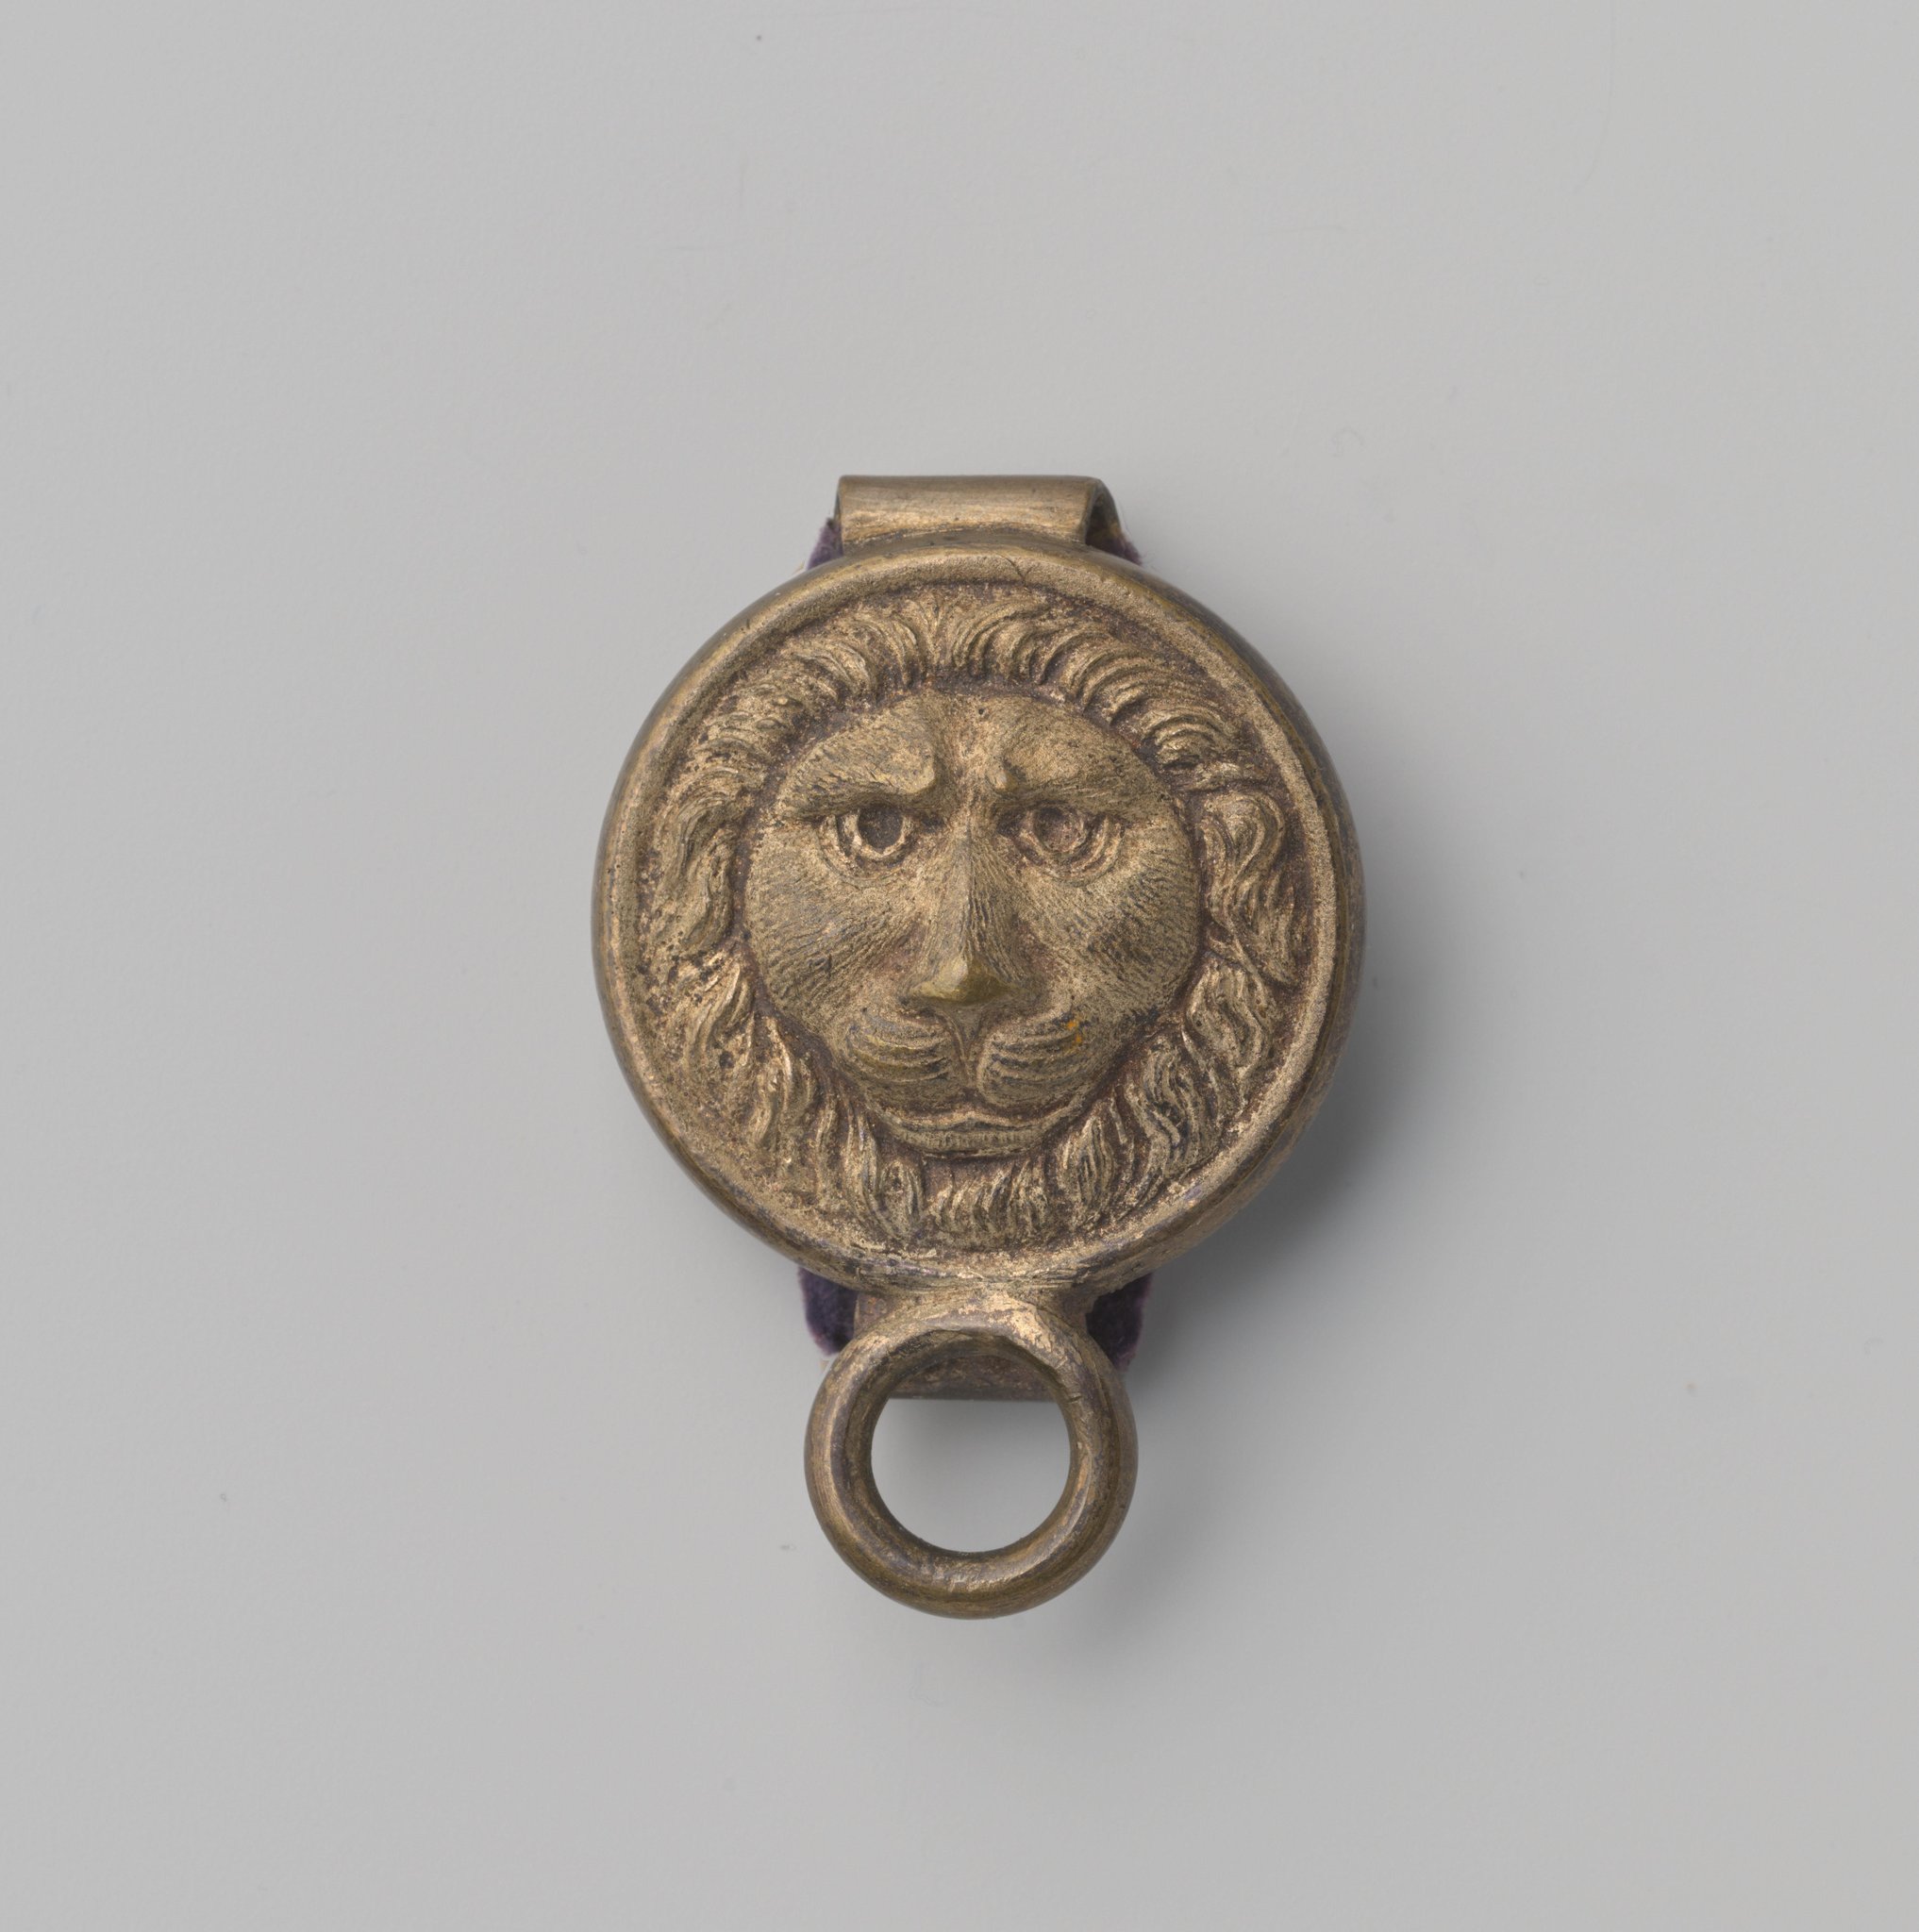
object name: buckle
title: Ronde gesp in de vorm van een leeuwenkop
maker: Anonymous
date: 1900-1925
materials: metal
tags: eugen wachenheimer, else wachenheimer-moos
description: Dit object is onderdeel van de nalatenschap van Isabel Elon-Wachenheimer (1928-2010). Tot haar overlijden behoorde het samen met de andere objecten uit de nalatenschap tot haar privédomein van Isabel Wachenheimer. In die particuliere context zijn deze objecten tezamen en individueel aandenkens - aan de jeugd, ouders en familie van Isabel Wachenheimer vóór en tijdens de Shoah en aan haar leven na de Tweede Wereldoorlog. Isabel Wachenheimer, die van juni 1943 tot mei 1945 gevangen zat in Kamp Westerbork, Theresienstadt, Auschwitz, Lenzing a/d Oberdonau (een buitenkamp van Mauthausen), overleefde de Shoah. Haar ouders – Eugène Wachenheimer en Else Wachenheimer-Moos - werden op 14 oktober 1944 in Auschwitz-Birkenau vermoord.